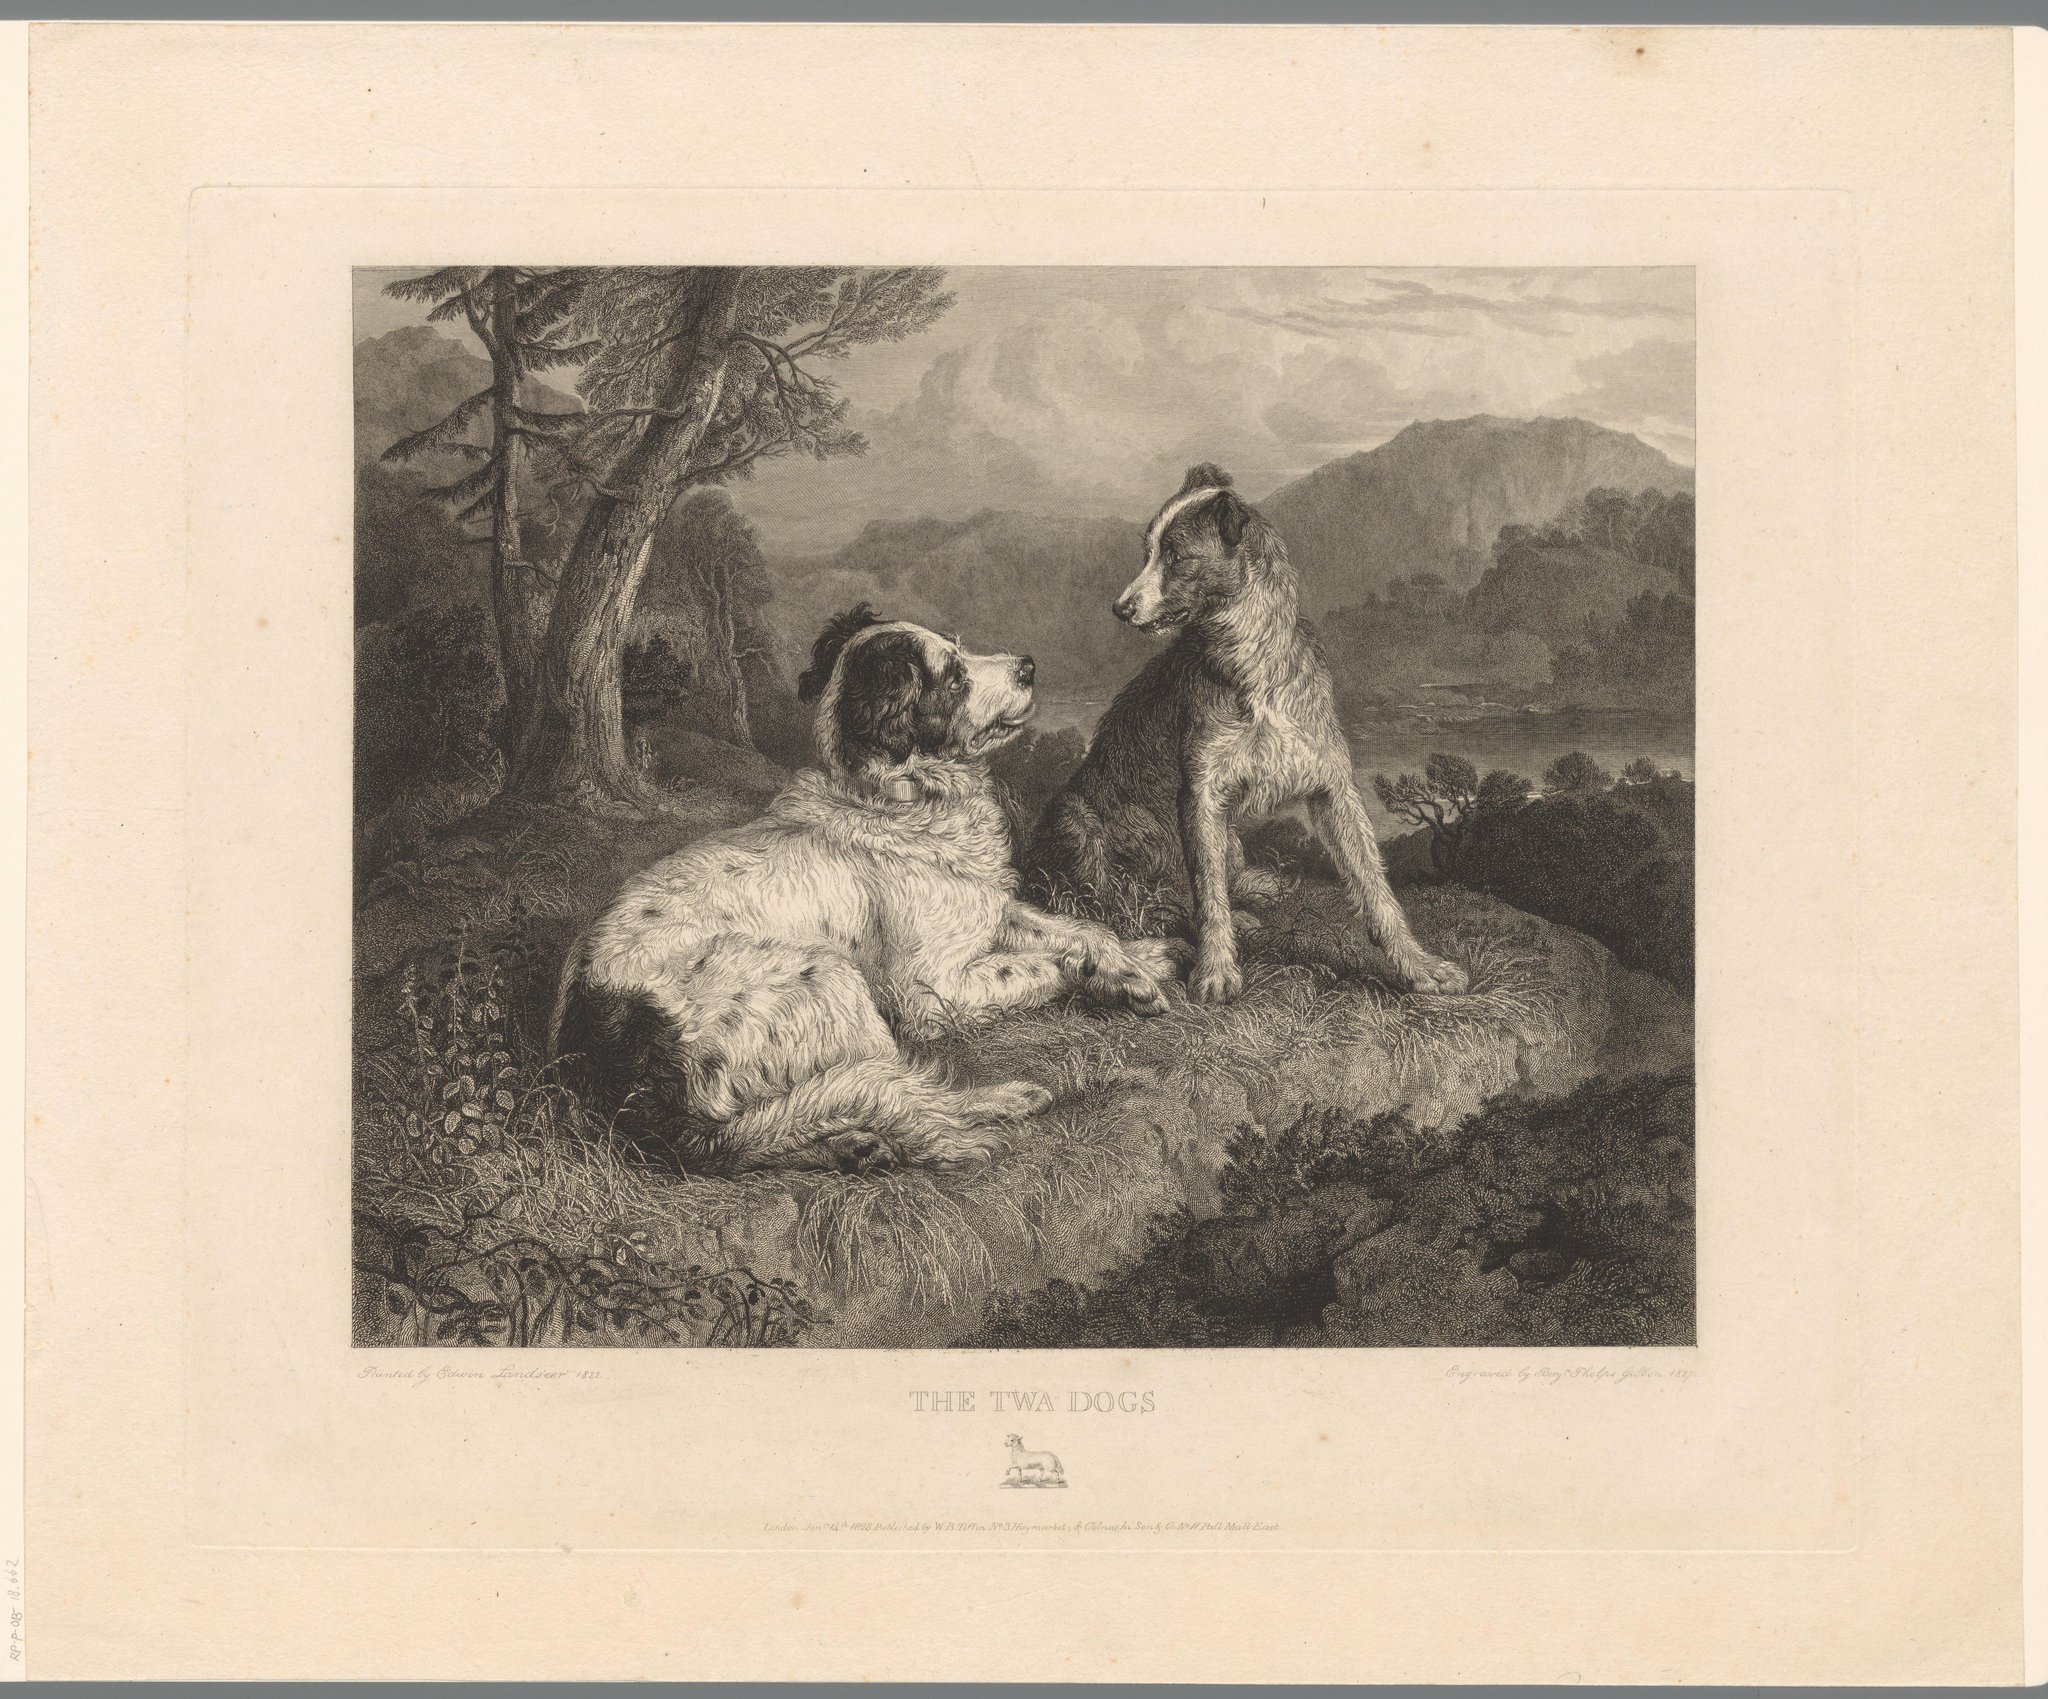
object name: print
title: The Twa Dogs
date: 1822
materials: paper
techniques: engraving, etching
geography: london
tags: low hill country (+ landscape with figures, staffage), dog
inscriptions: collector's mark: Lugt 12